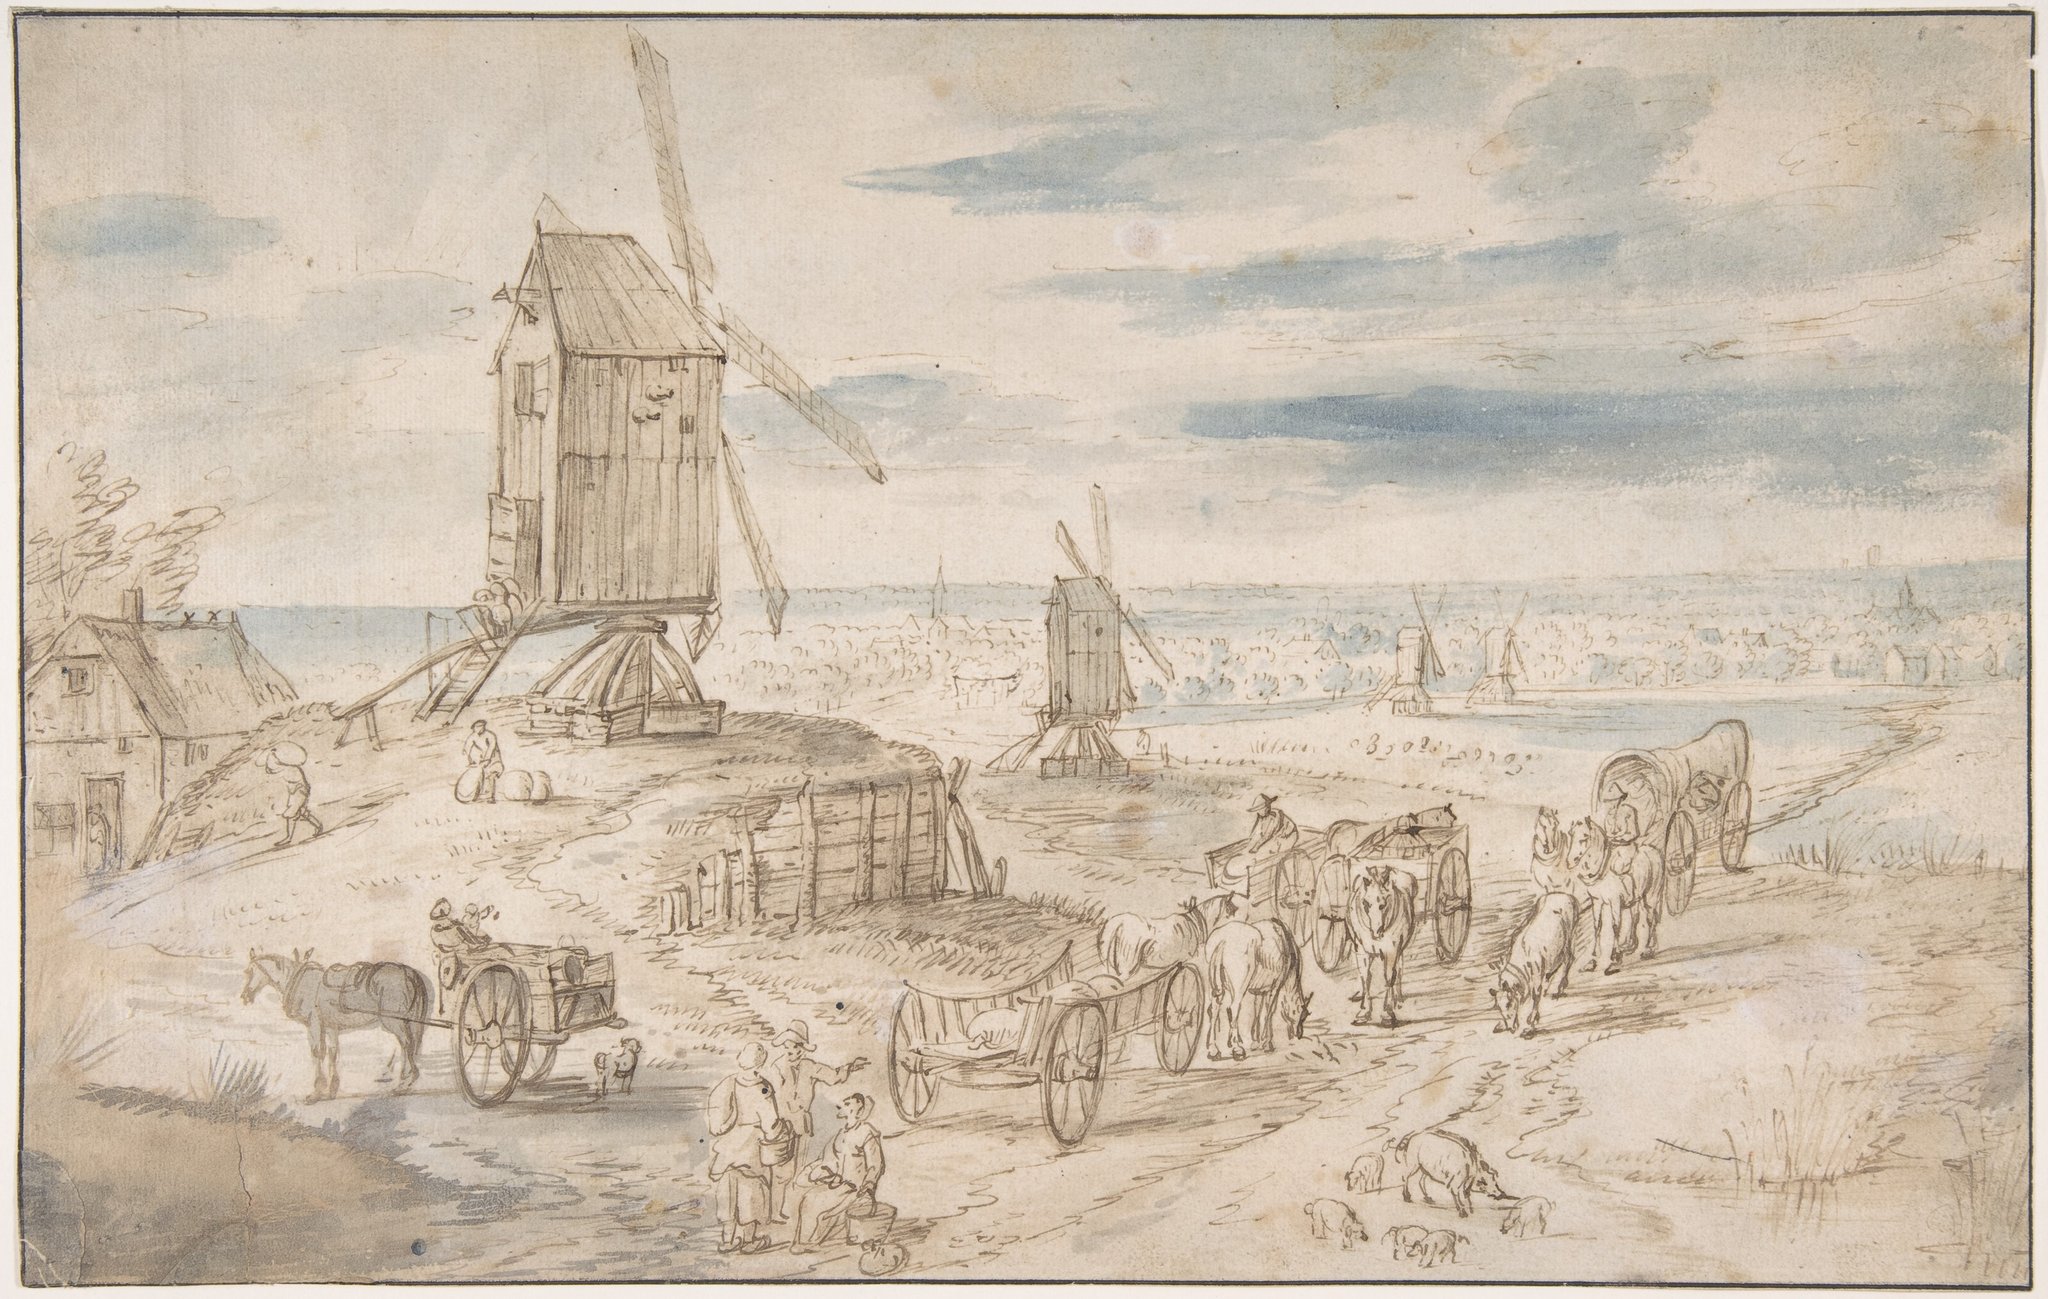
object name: drawing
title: Dutch Landscape with Windmills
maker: jan brueghel the elder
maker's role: artist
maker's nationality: netherlandish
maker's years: 1568-1625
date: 1601-1700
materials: ink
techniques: brush, pen, wash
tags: houses,windmills,horses,landscapes,carriages